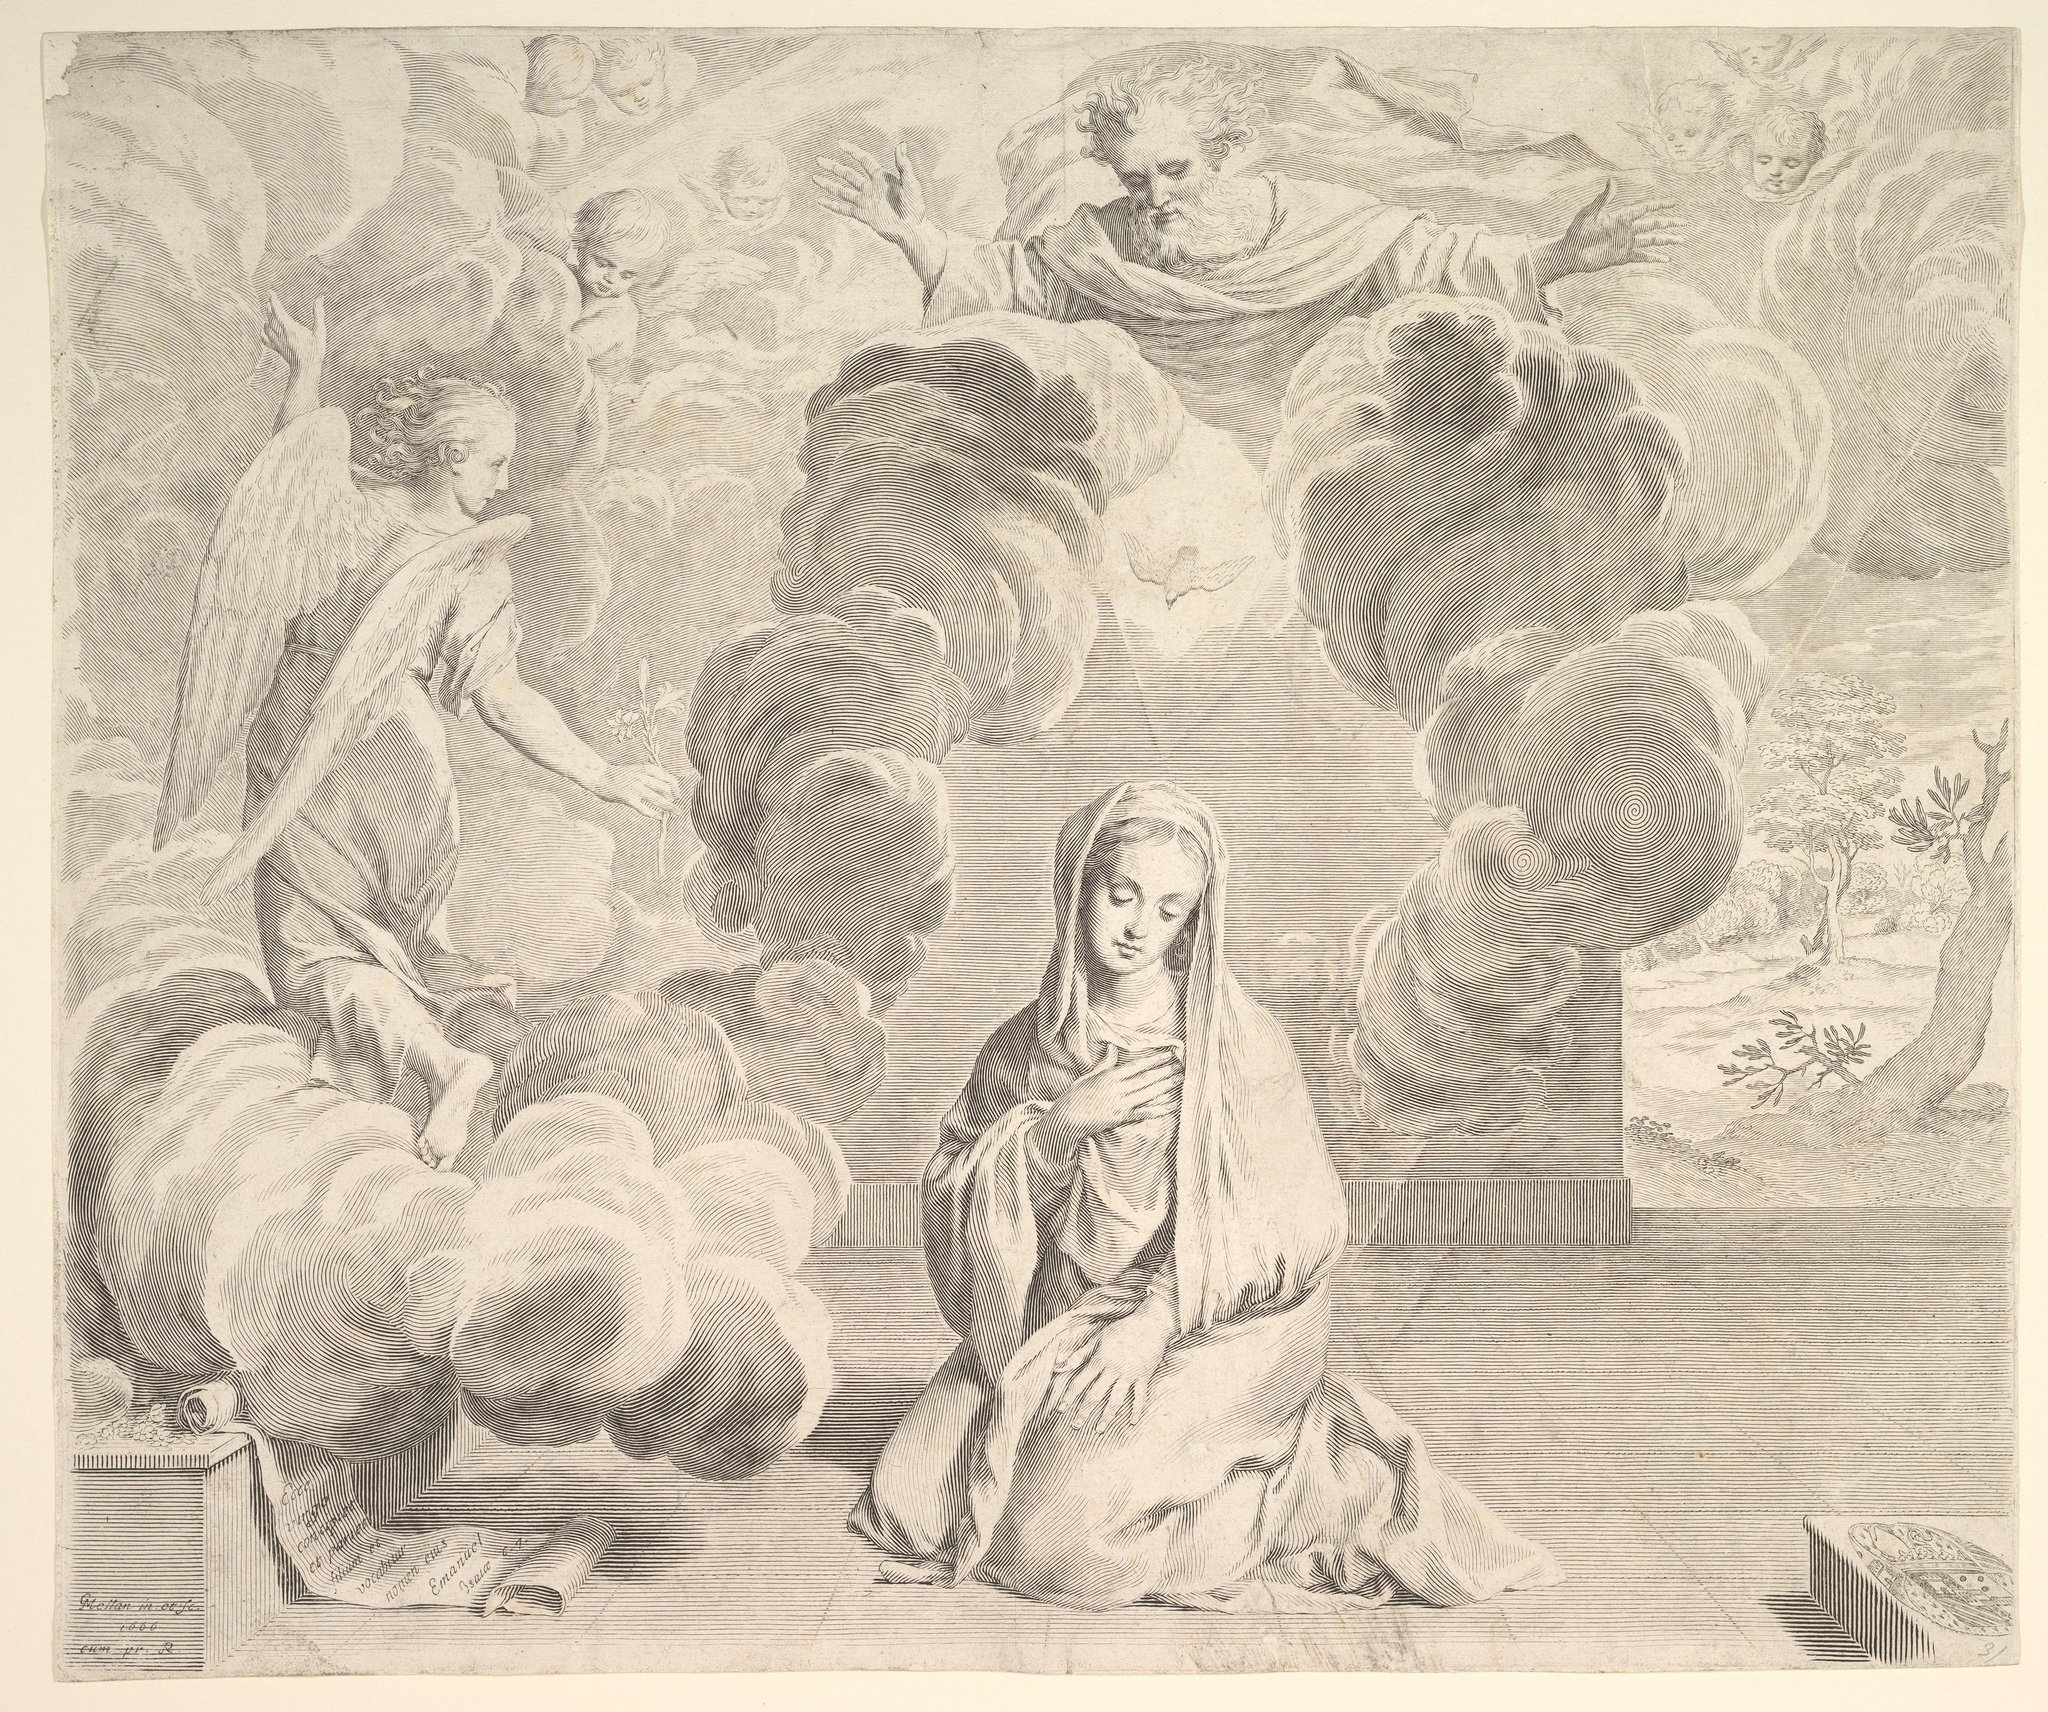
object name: print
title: Annunciation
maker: claude mellan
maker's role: artist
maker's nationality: french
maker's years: 1598-1688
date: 1666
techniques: engraving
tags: angels,annunciation